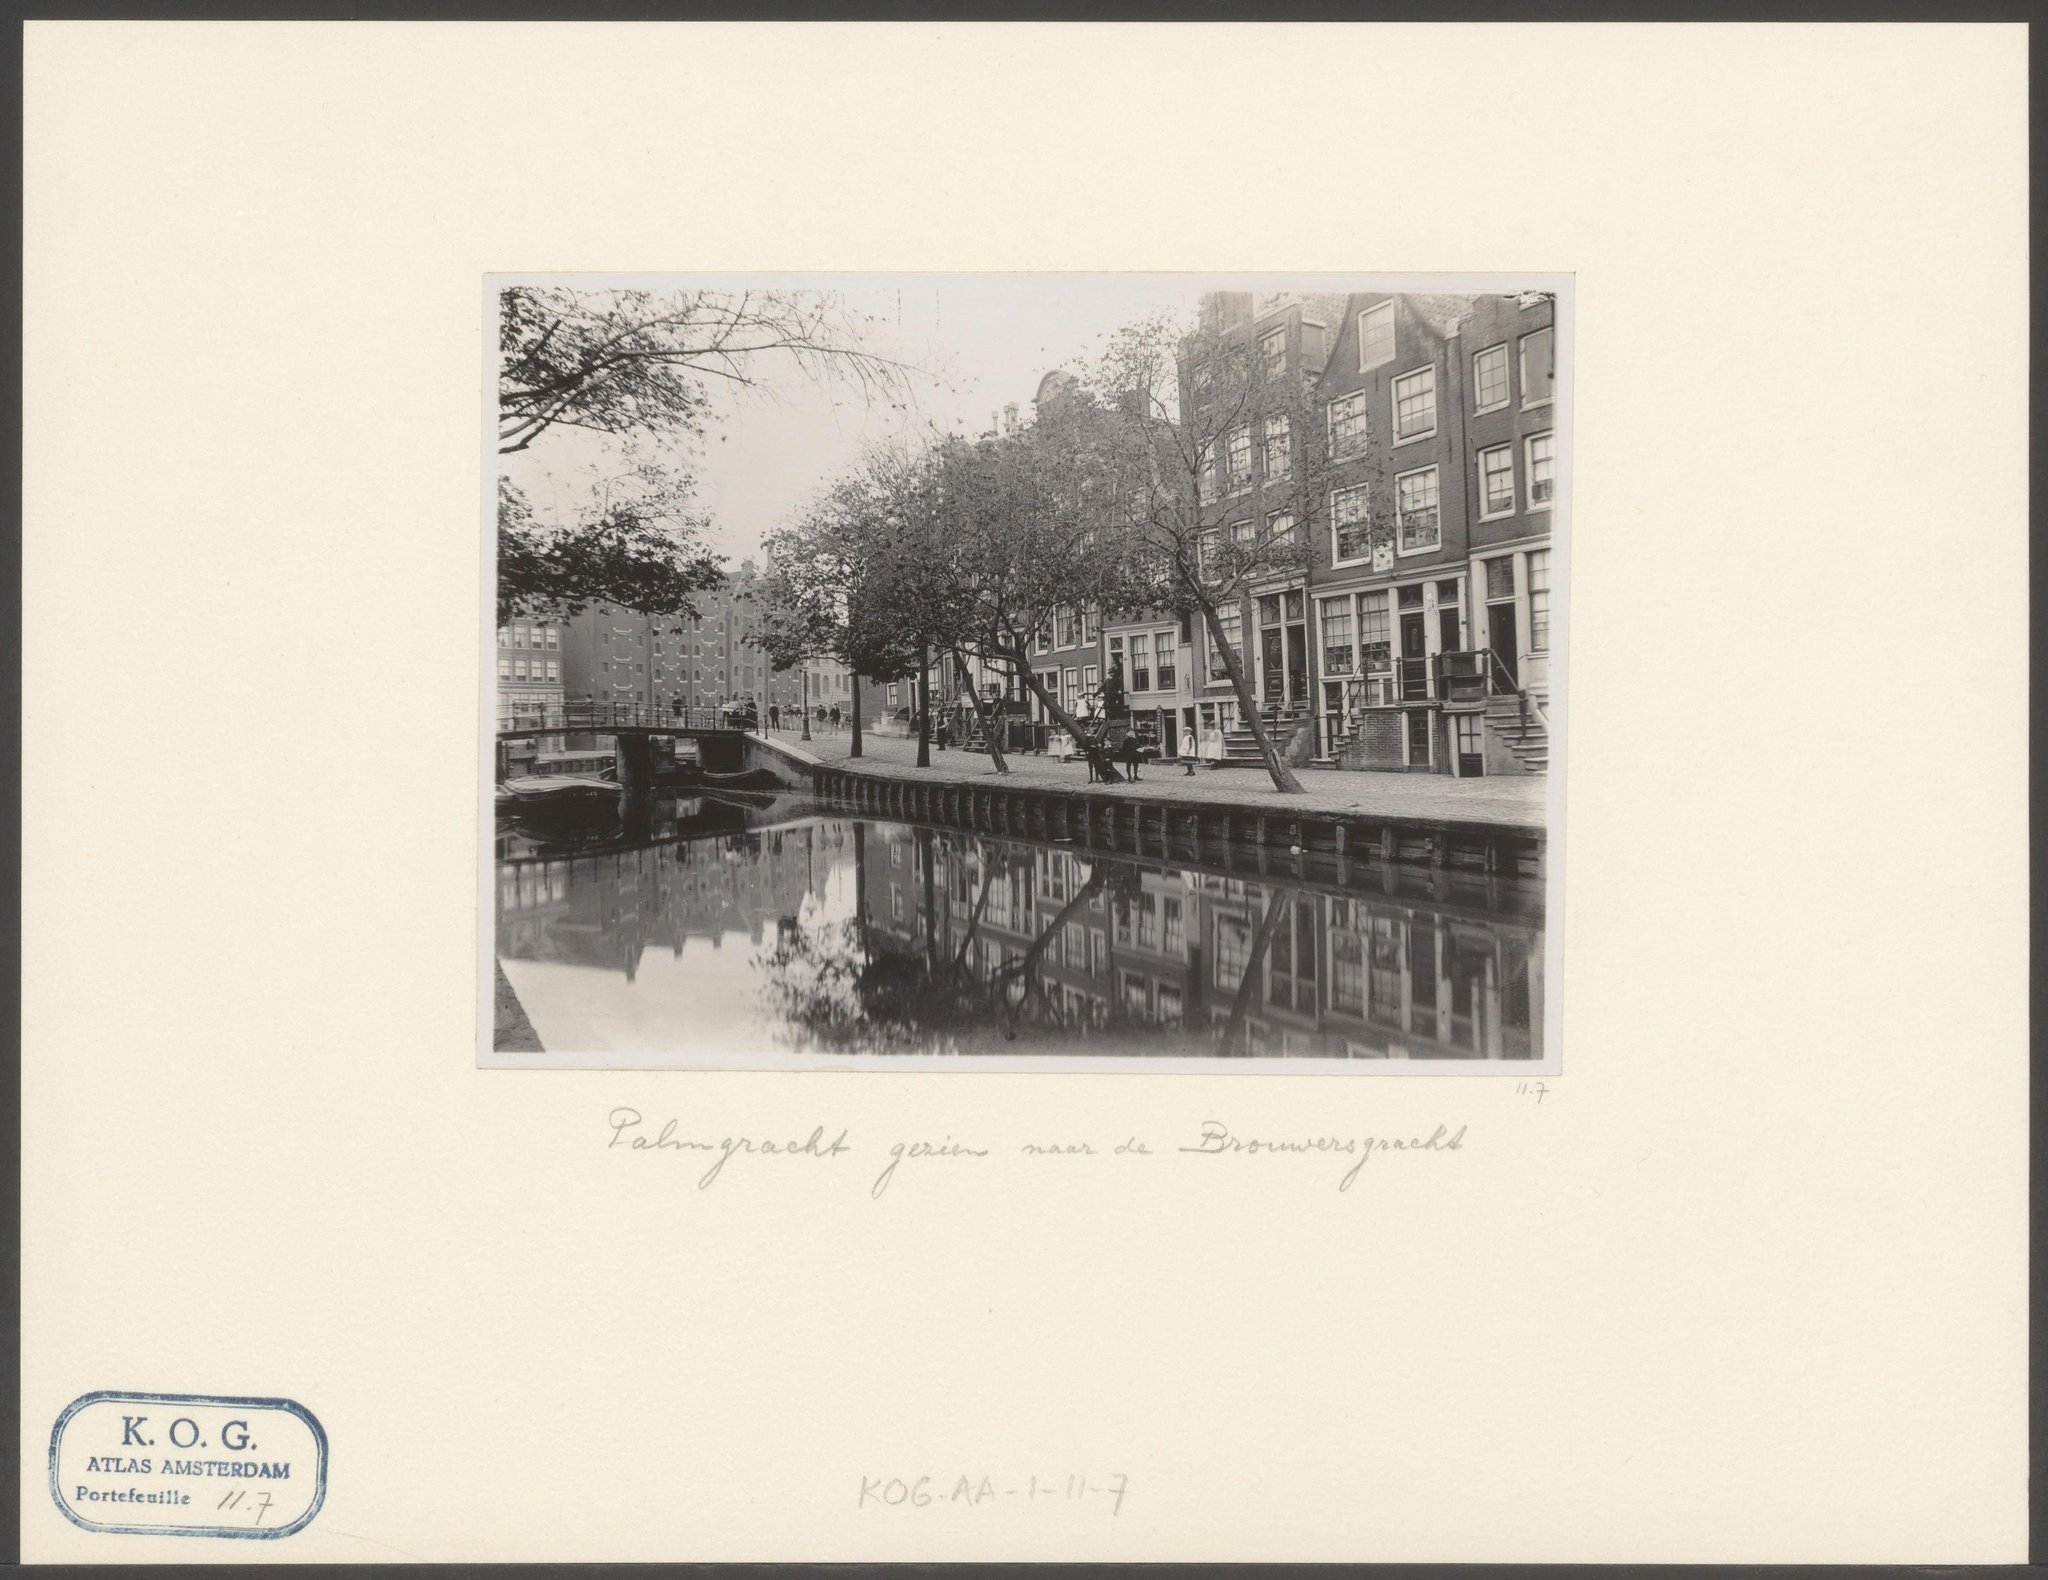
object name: photograph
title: Gezicht op de Palmgracht, gezien naar de Brouwersgracht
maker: Anonymous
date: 1880-1950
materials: paper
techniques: gelatin silver print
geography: amsterdam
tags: city-view in general; 'veduta', canal, the usual house or row of houses, bridge in city across river, canal, etc., street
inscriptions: inscription: ‘Palmgracht gezien naar de Brouwersgracht’, collector's mark: ‘11.7’ Lugt 1641b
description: Onderwerpsrubriek binnen de Atlas Amsterdam: Paleisstraat, Palmgracht, Papenbrugsteeg, Passeerdersgracht, Peperstraat, Pieterspoort (St.), Pieterssteeg (St.), Plantage, Prinseneiland.